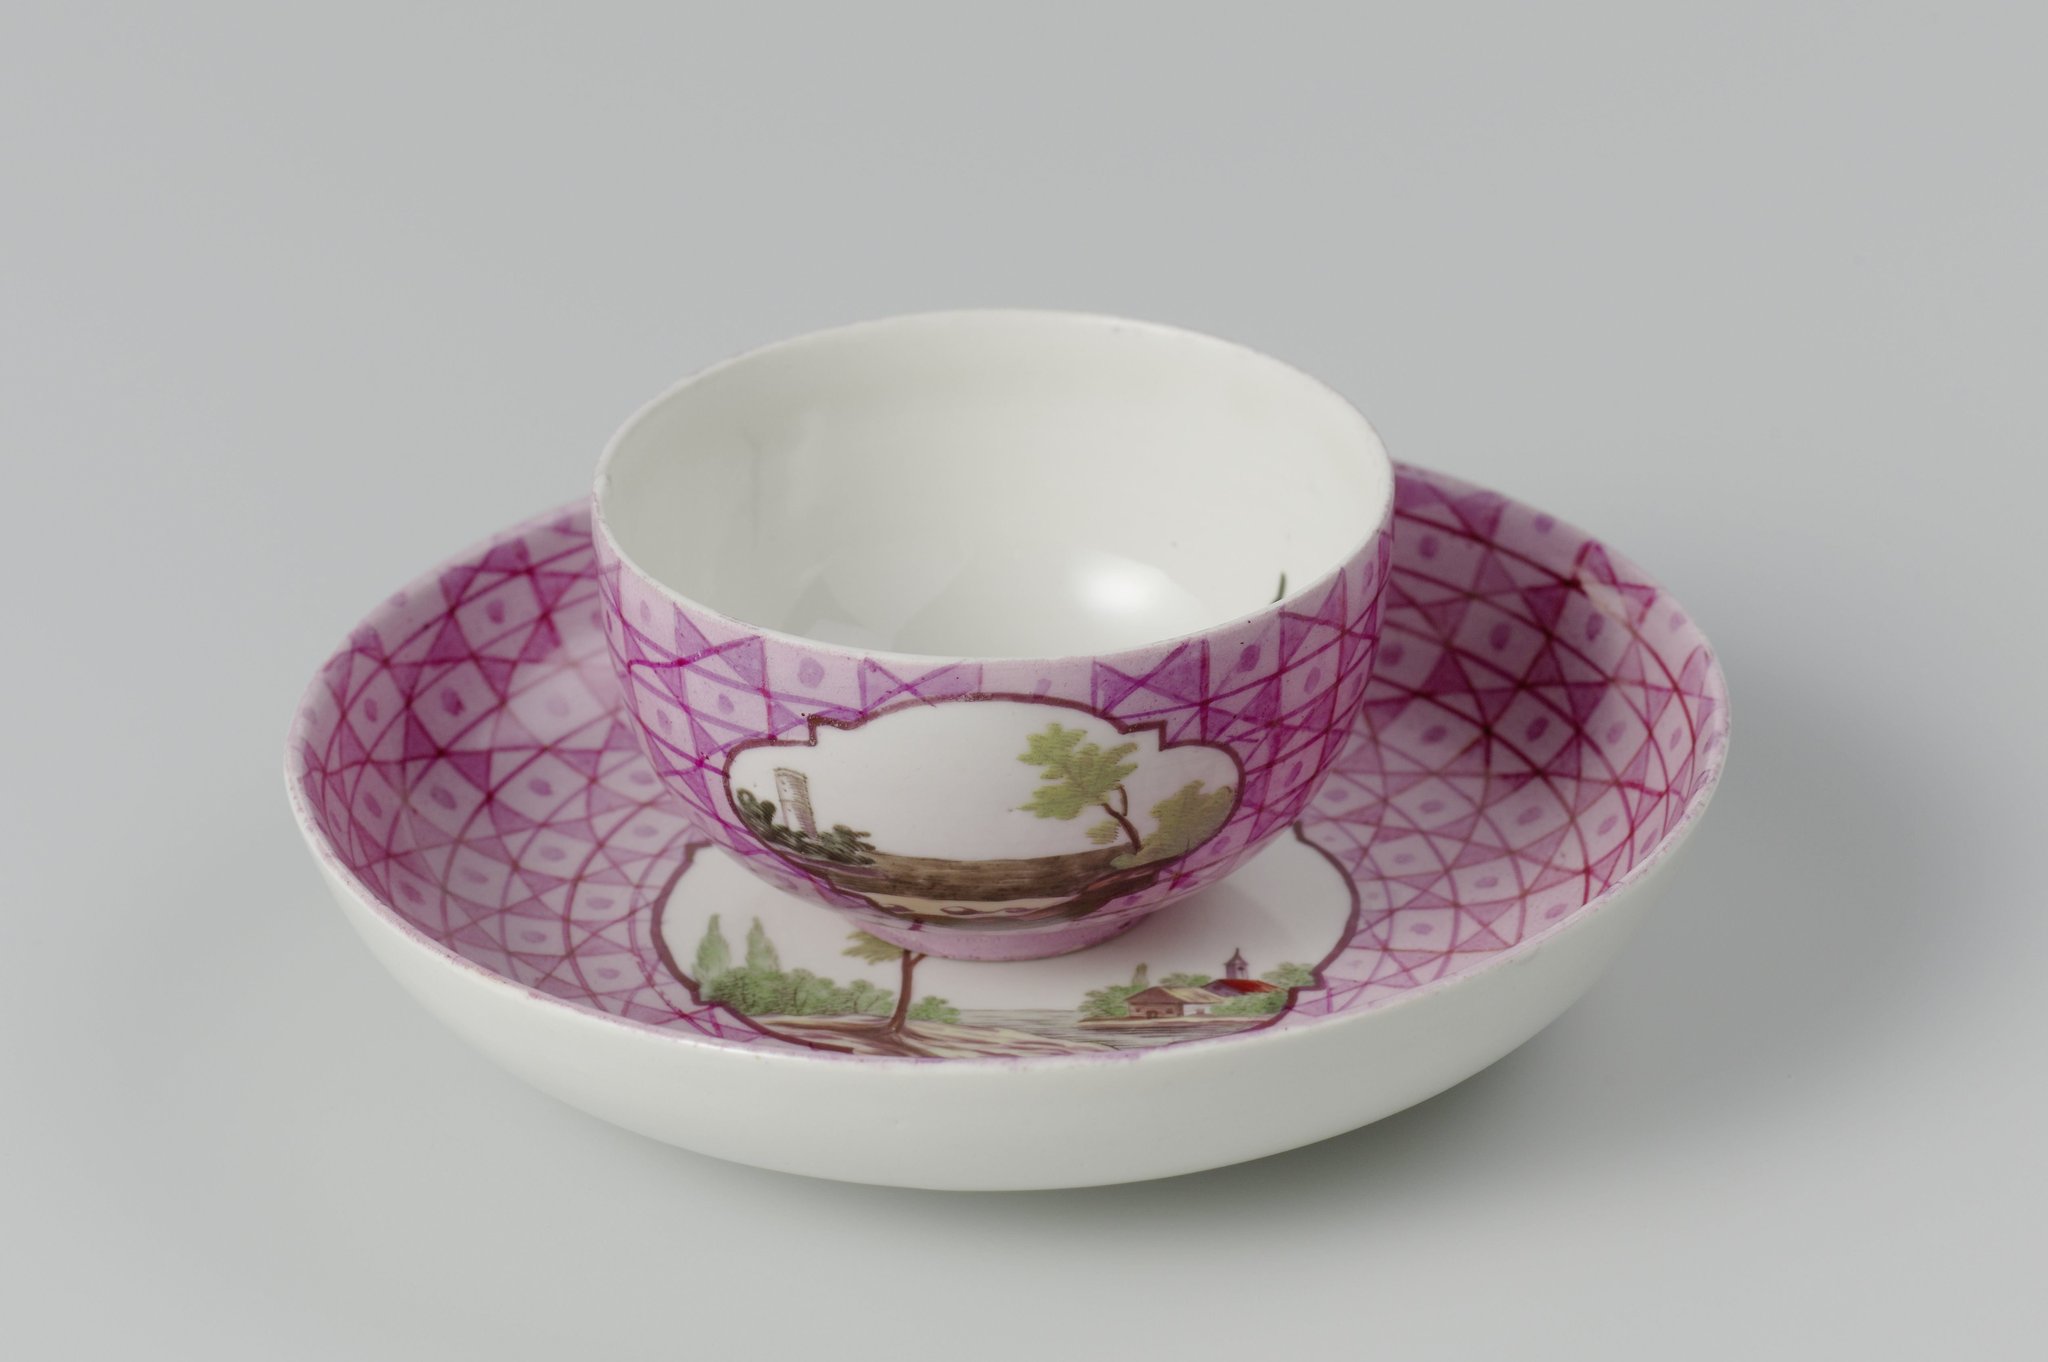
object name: kop en schotel, kop en schotel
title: Kop en schotel met een veelkleurig landschap in een medaillon uitgespaard in een geometrisch patroon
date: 1759-1771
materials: porcelain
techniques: painted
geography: weesp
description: Kop en schotel met een veelkleurig landschap in een medaillon gespaard in een paars geometrisch patroon. Gemerkt met twee gekruiste zwaarden en drie bollen in onderglazuurblauw, ingegrift 2.